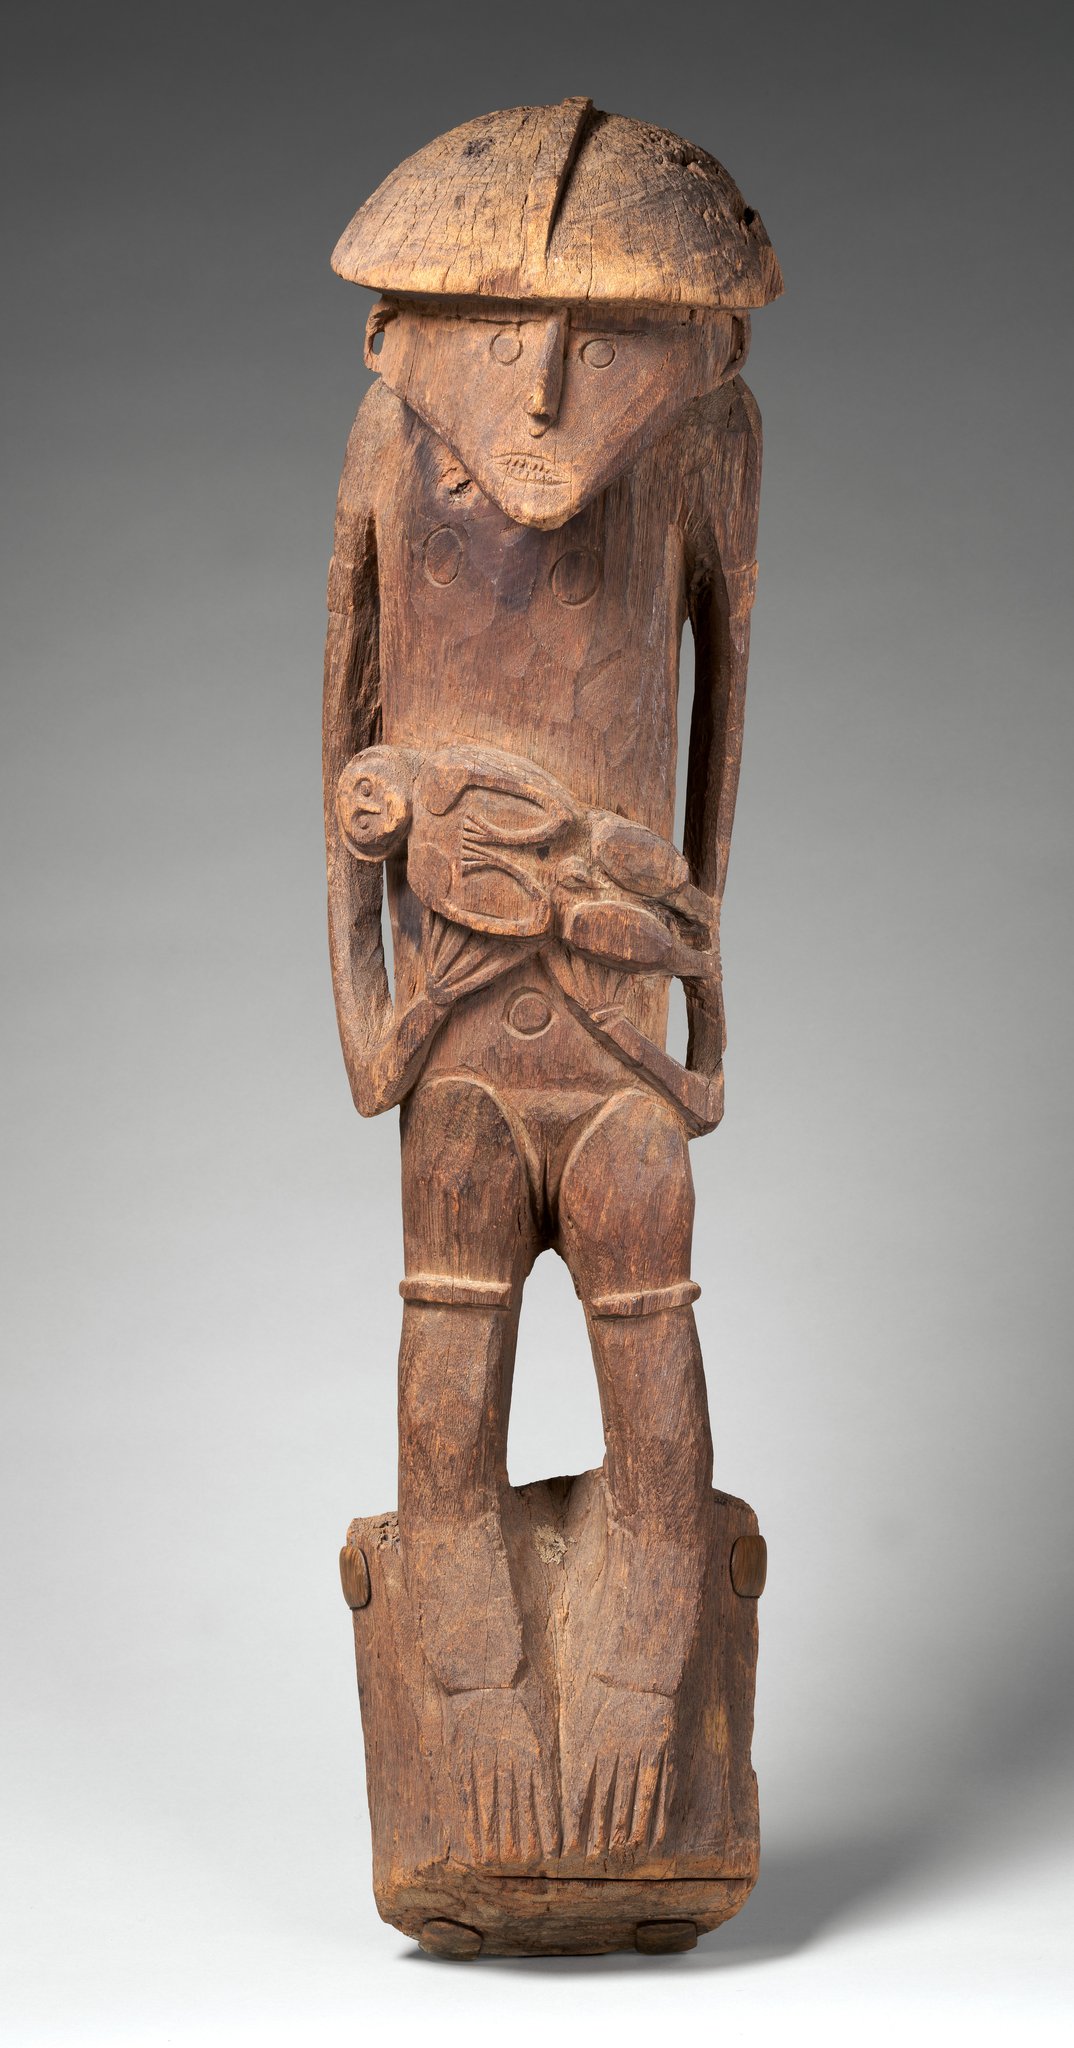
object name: house post figure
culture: sentani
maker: lake sentani artist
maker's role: artist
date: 1801-1900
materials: wood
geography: indonesia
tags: children,mothers,women